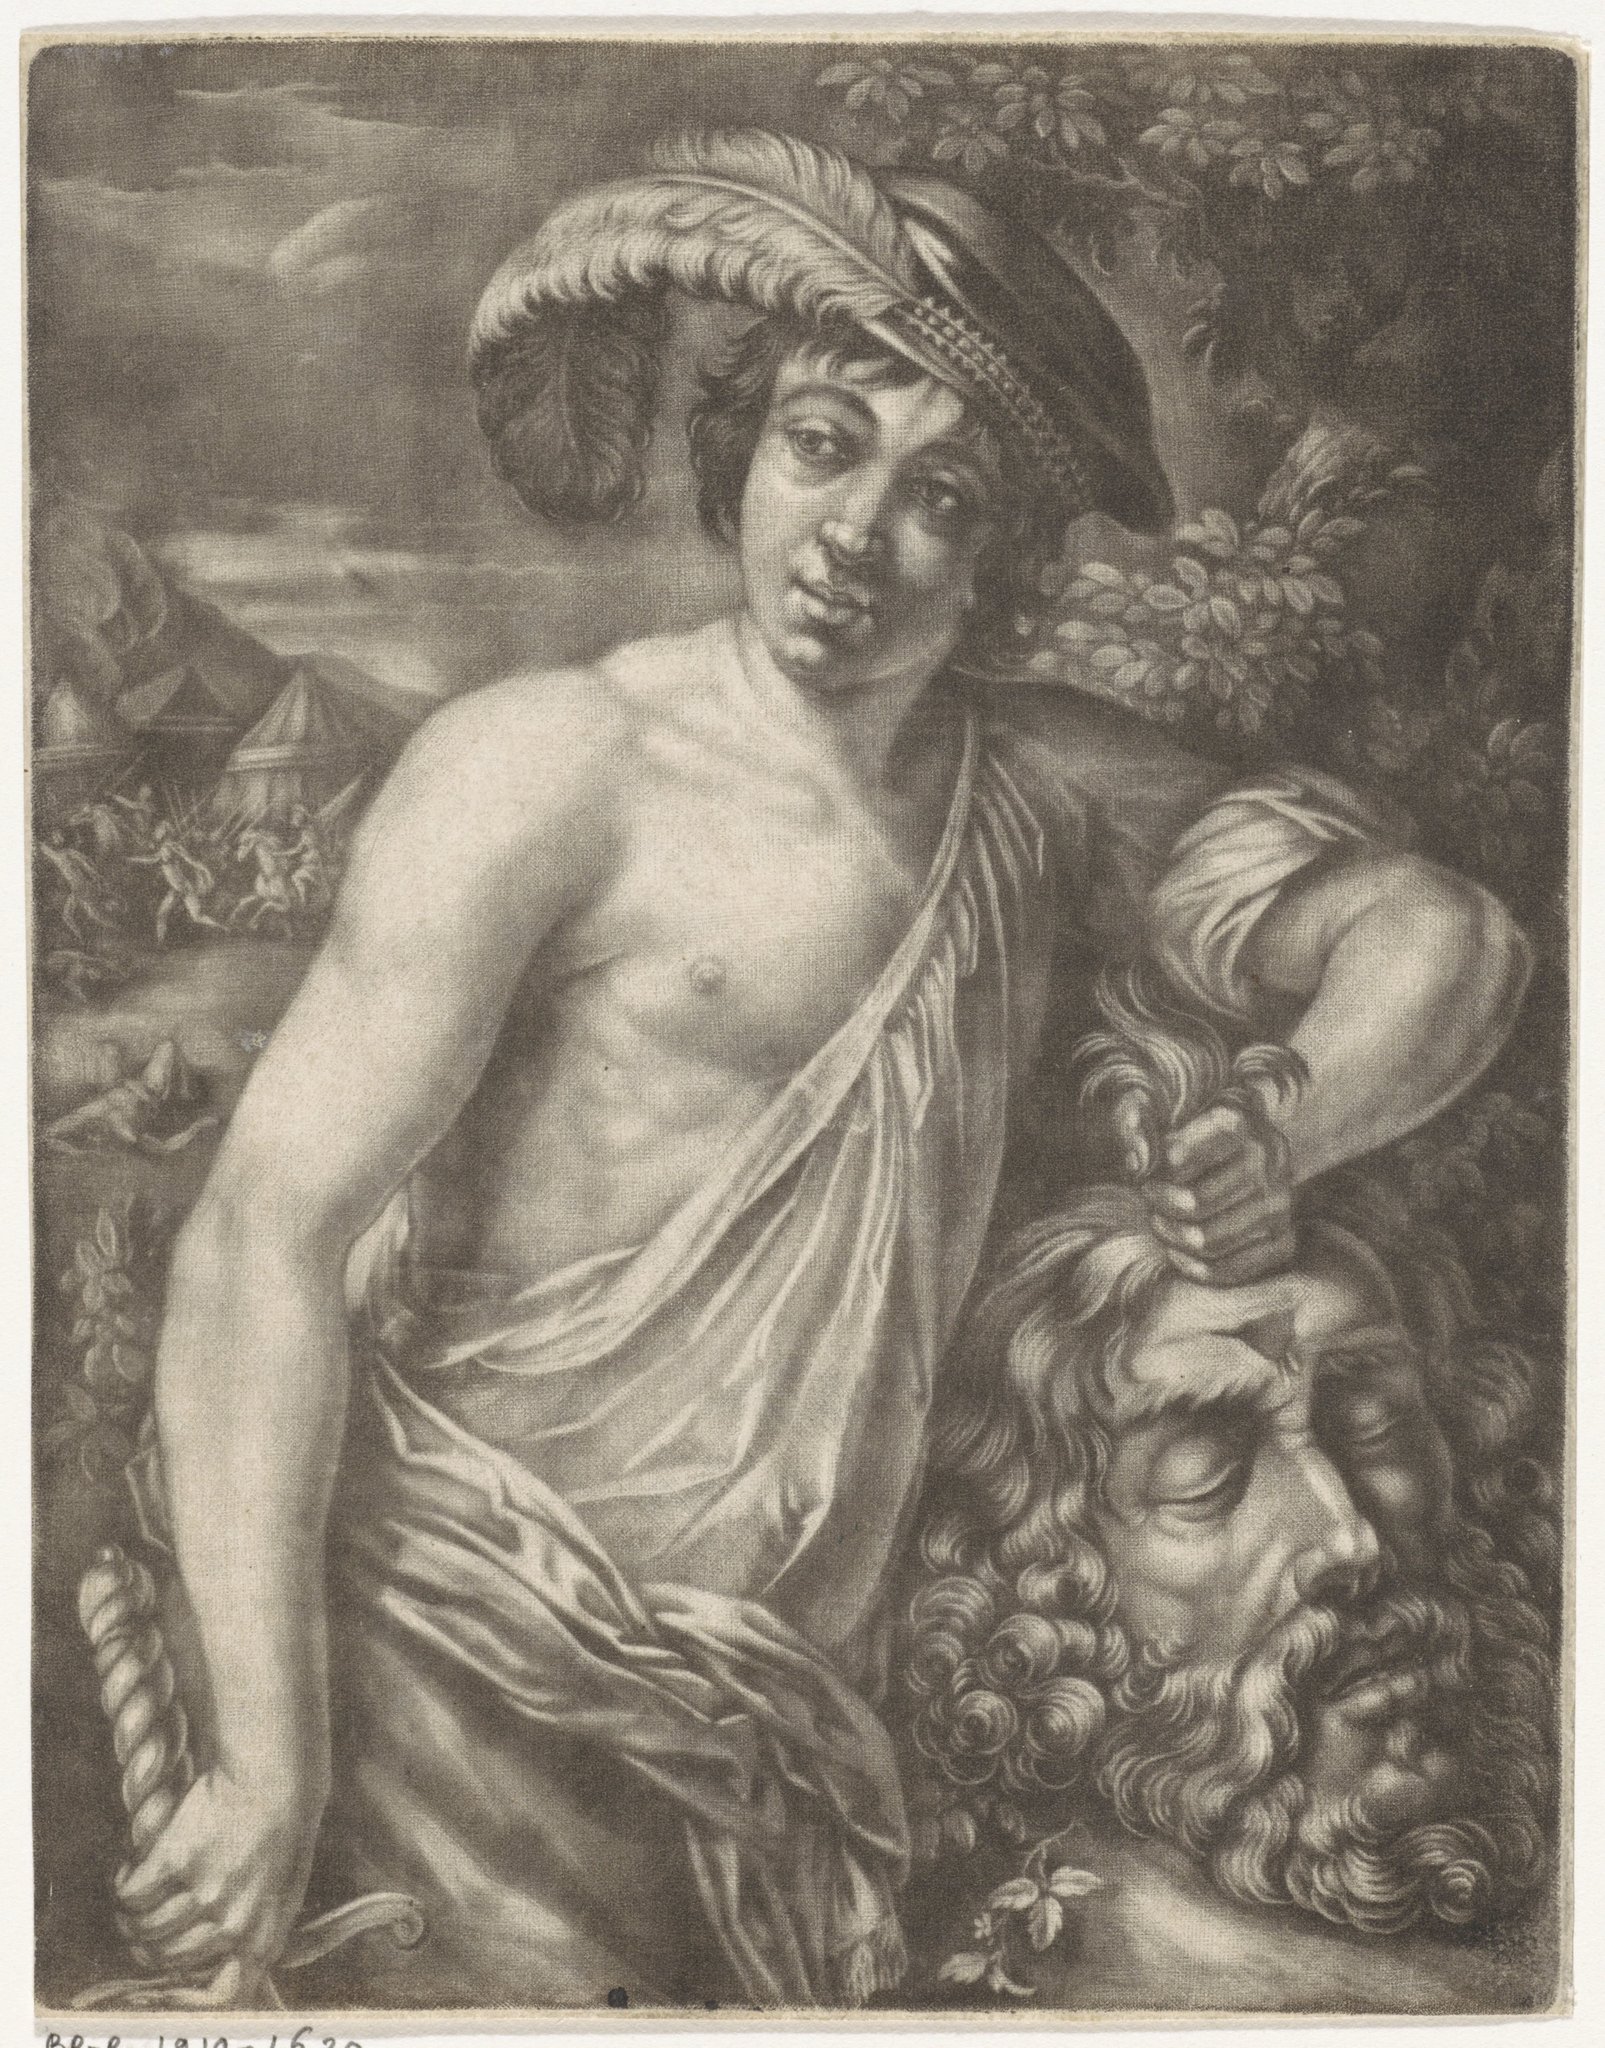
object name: print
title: David met het hoofd van Goliath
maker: Anonymous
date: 1650-1800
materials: paper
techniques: mezzotint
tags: david with goliath's head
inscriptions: collector's mark: Lugt 514, collector's mark: Lugt 2228